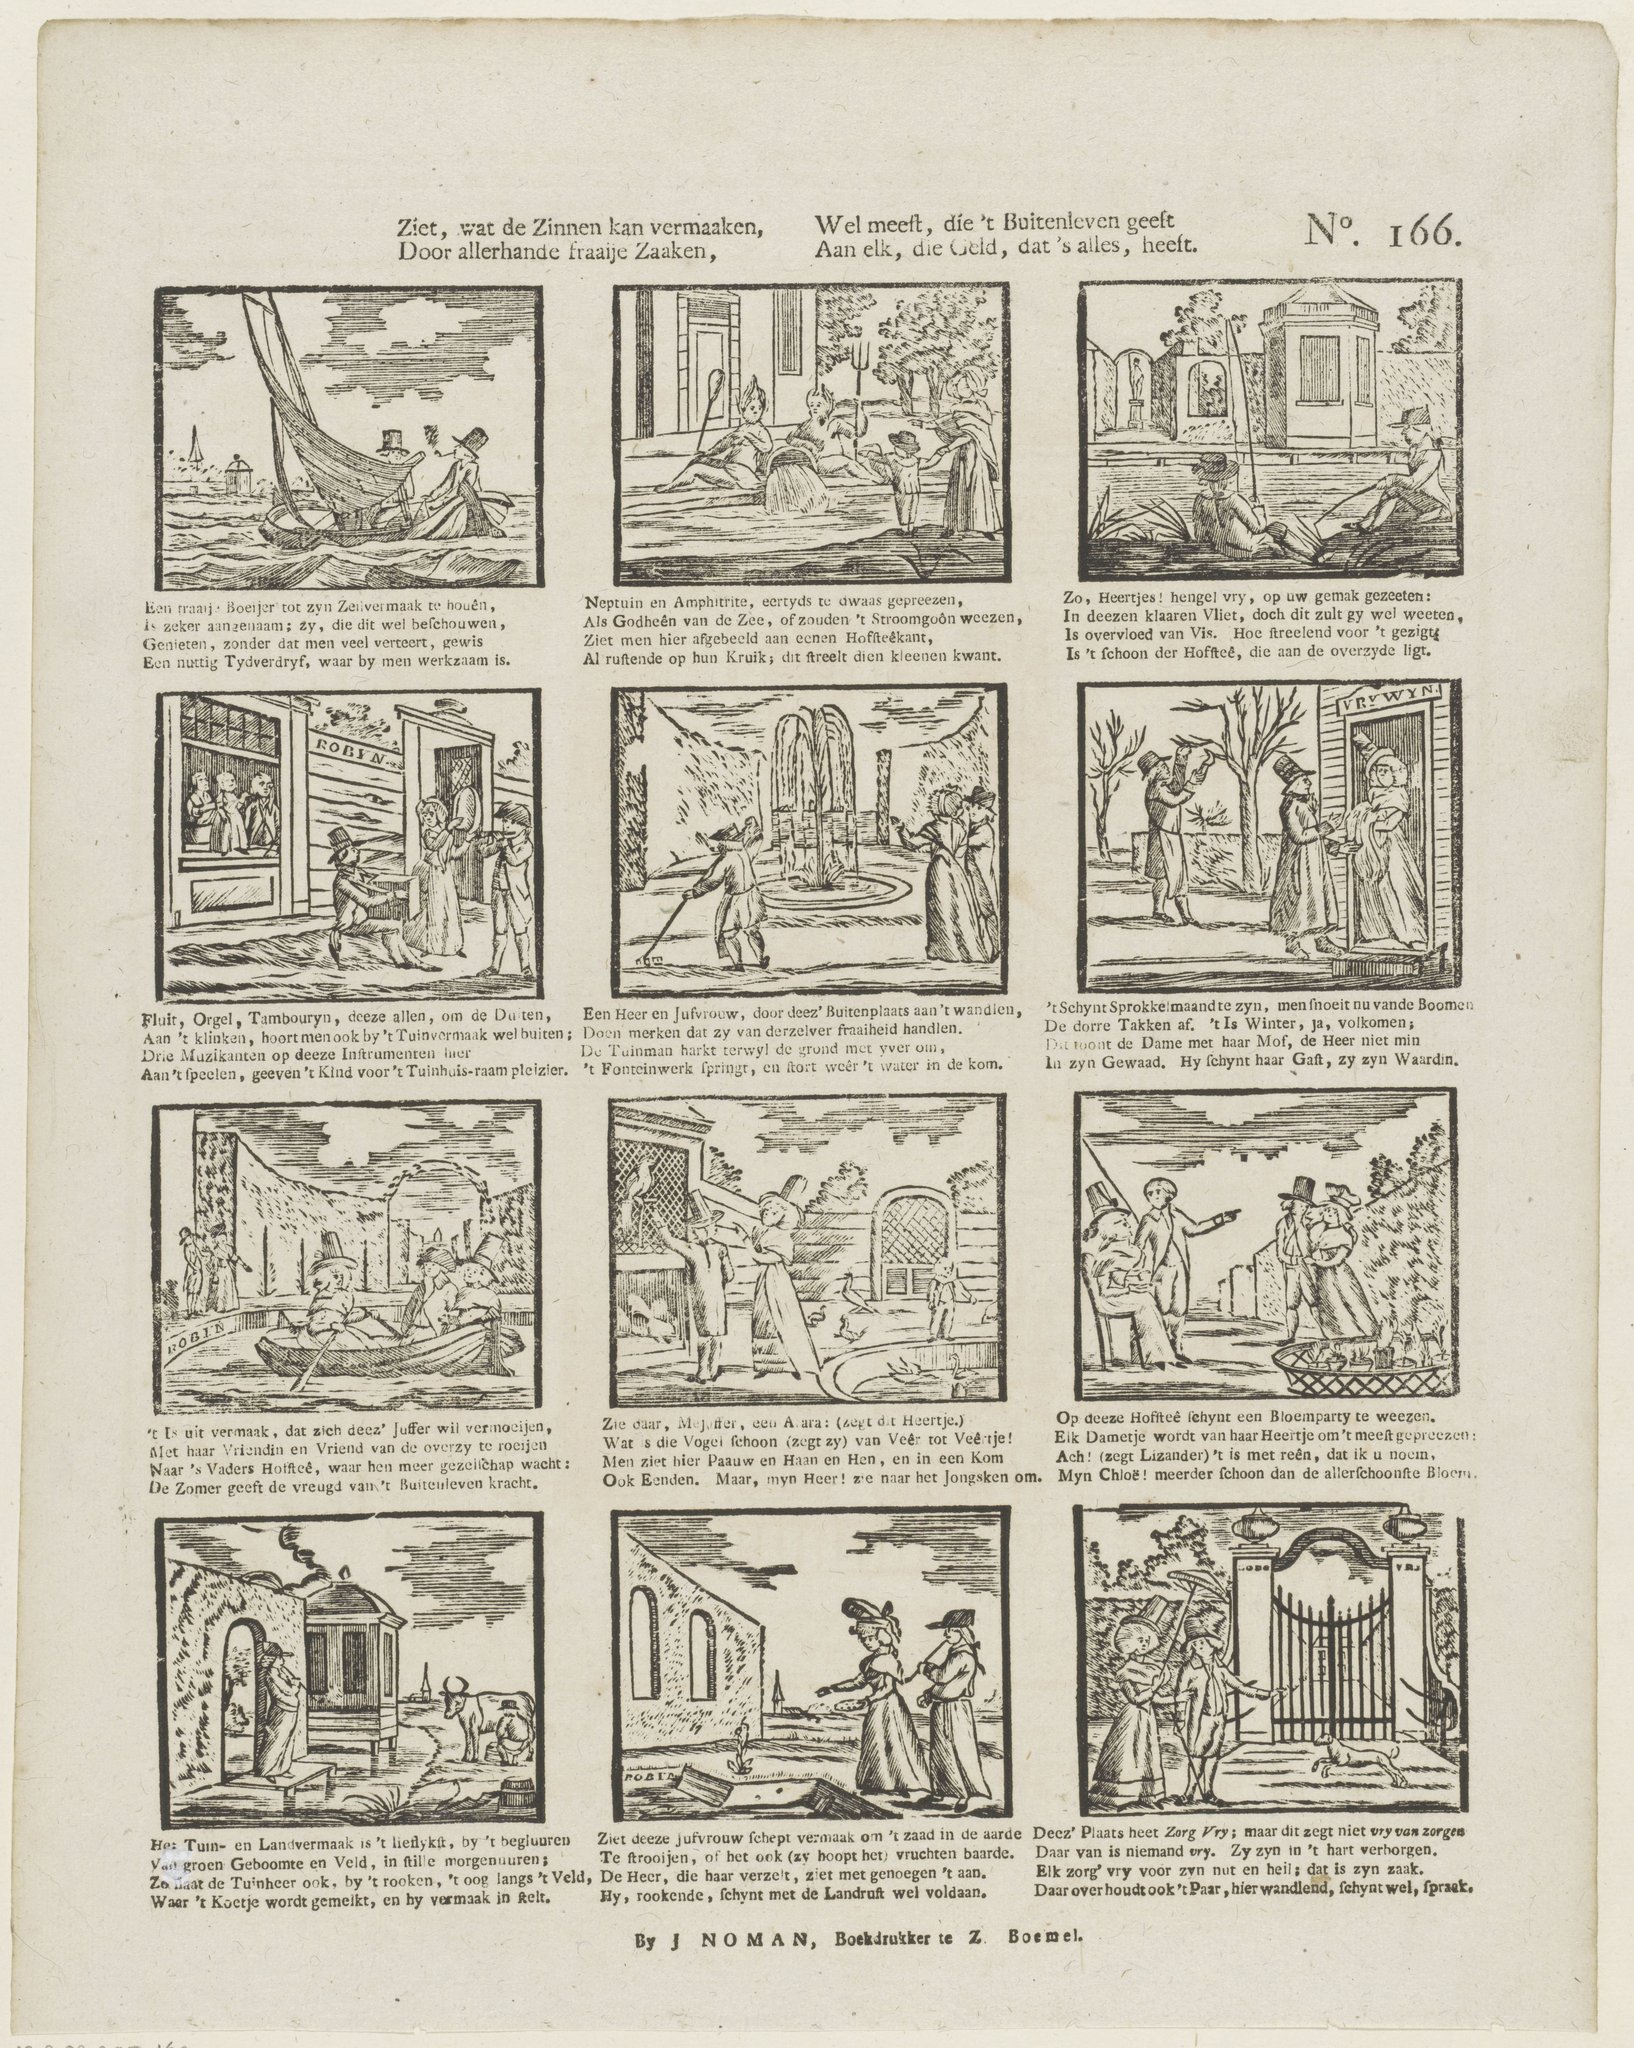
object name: print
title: Ziet, wat de zinnen kan vermaaken, / Door allerhande fraaije zaaken, / Wel meest, die 't buitenleven geeft / Aan elk, die geld, dat 's alles, heeft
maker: johan noman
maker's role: printer, publisher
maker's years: -1833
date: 1806-1830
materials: paper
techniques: letterpress printing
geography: zaltbommel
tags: human types, garden fountain, fishing (sports), couple of lovers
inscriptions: collector's mark: Lugt 2760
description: Blad met 12 voorstellingen van verschillende figuren en bezigheden. Onder elke afbeelding een vierregelig vers. Genummerd rechtsboven: No. 166.